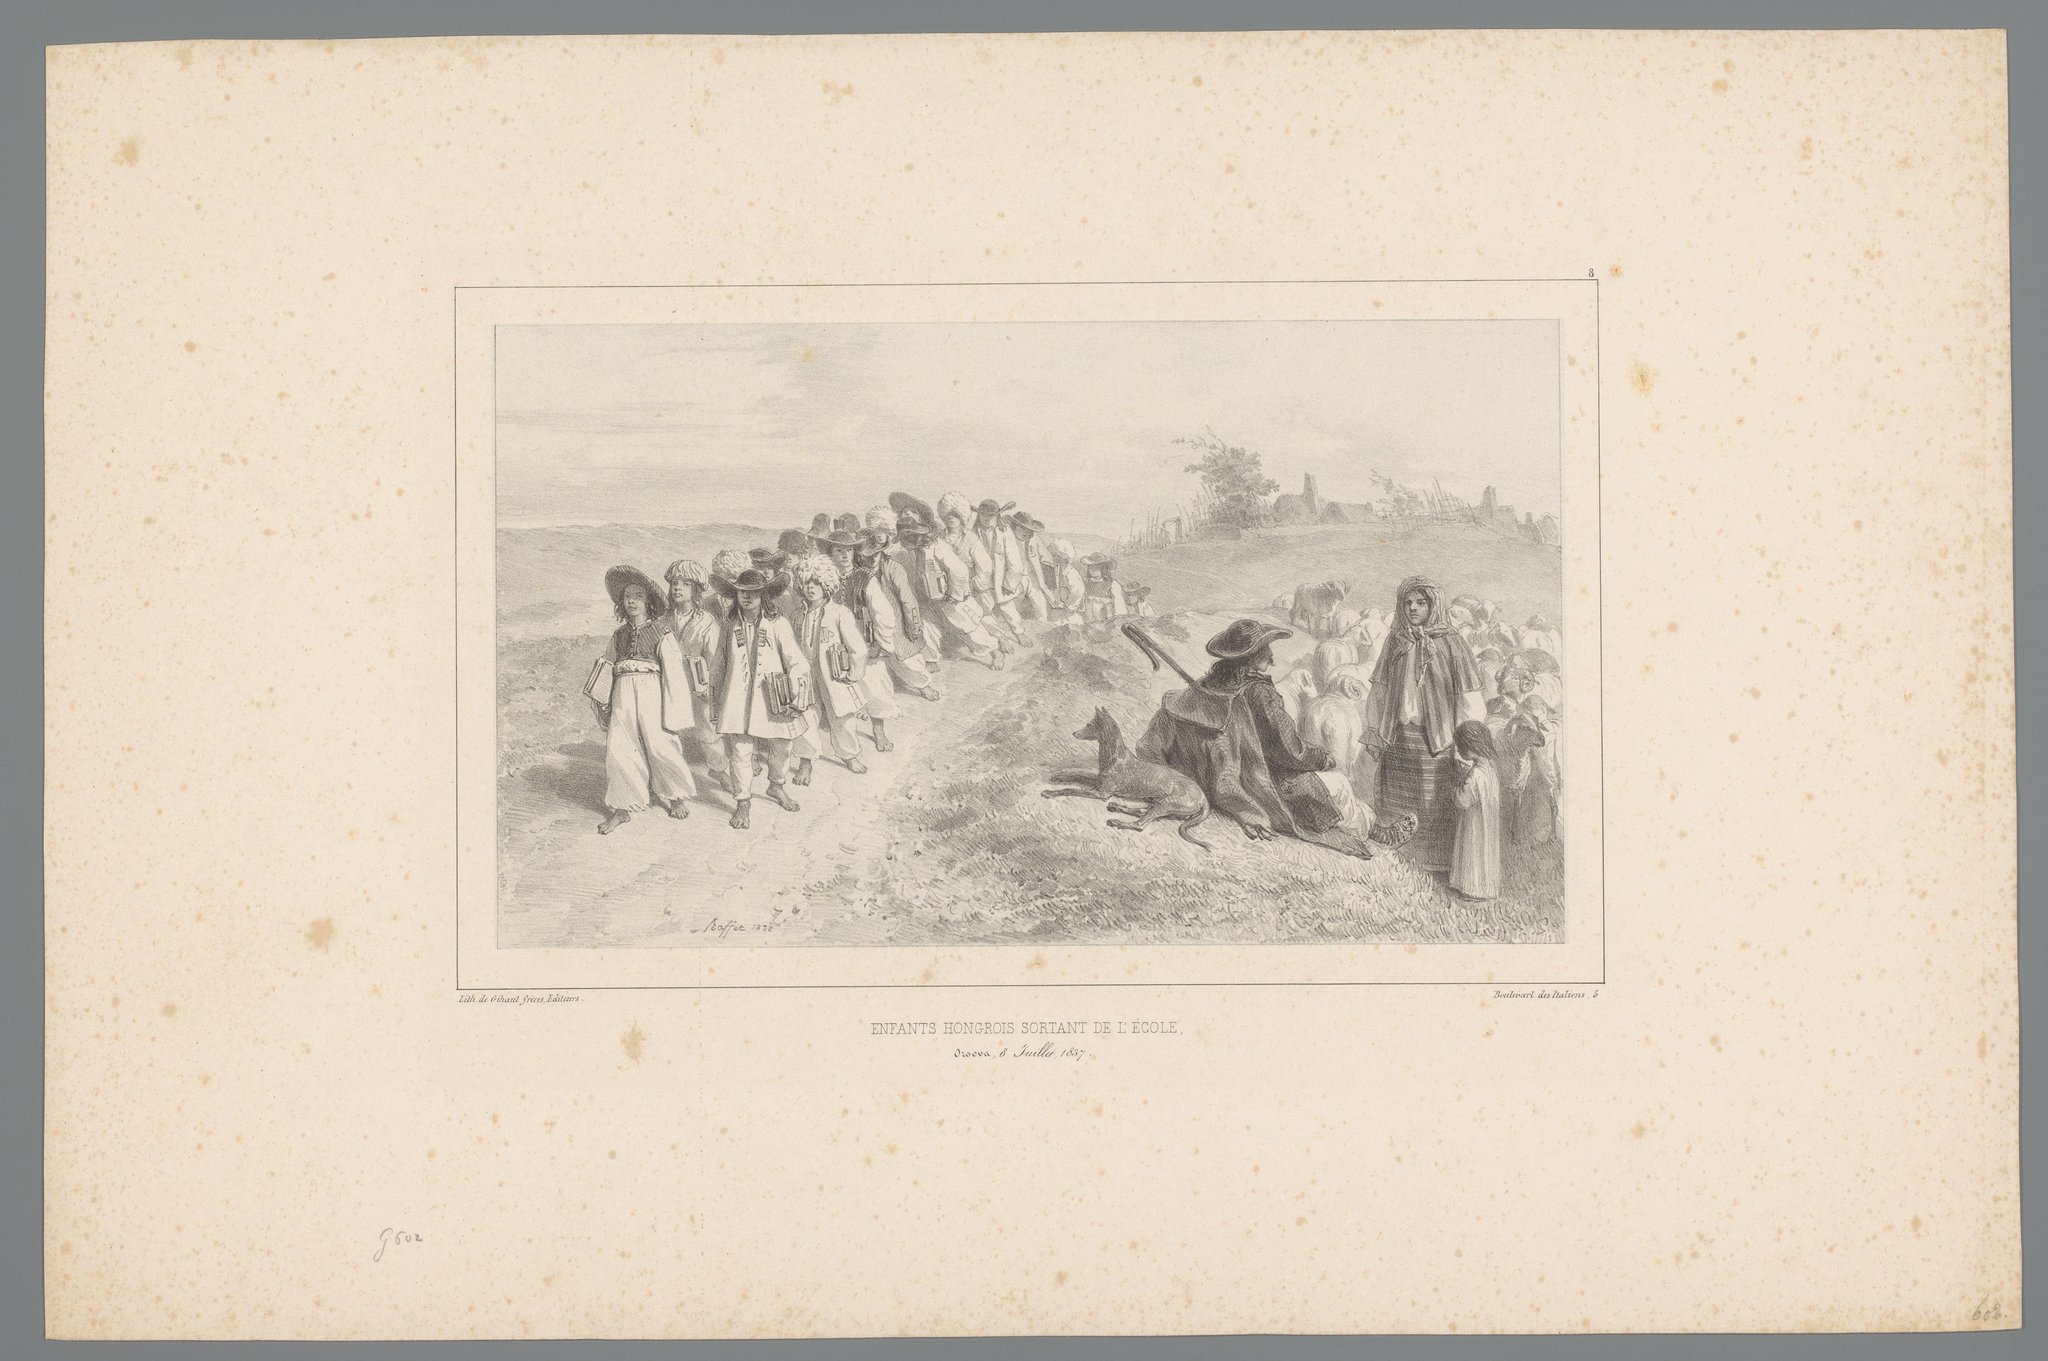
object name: print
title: Enfants hongrois sortant de l'école (...) 8 juillet, 1837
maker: denis auguste marie raffet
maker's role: draughtsman, print maker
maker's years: 1804-1860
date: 1838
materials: paper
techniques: lithograph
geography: paris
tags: herding, herdsman, herdswoman, shepherd, shepherdess, cowherd, etc., child, returning home from school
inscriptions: collector's mark: Lugt 964